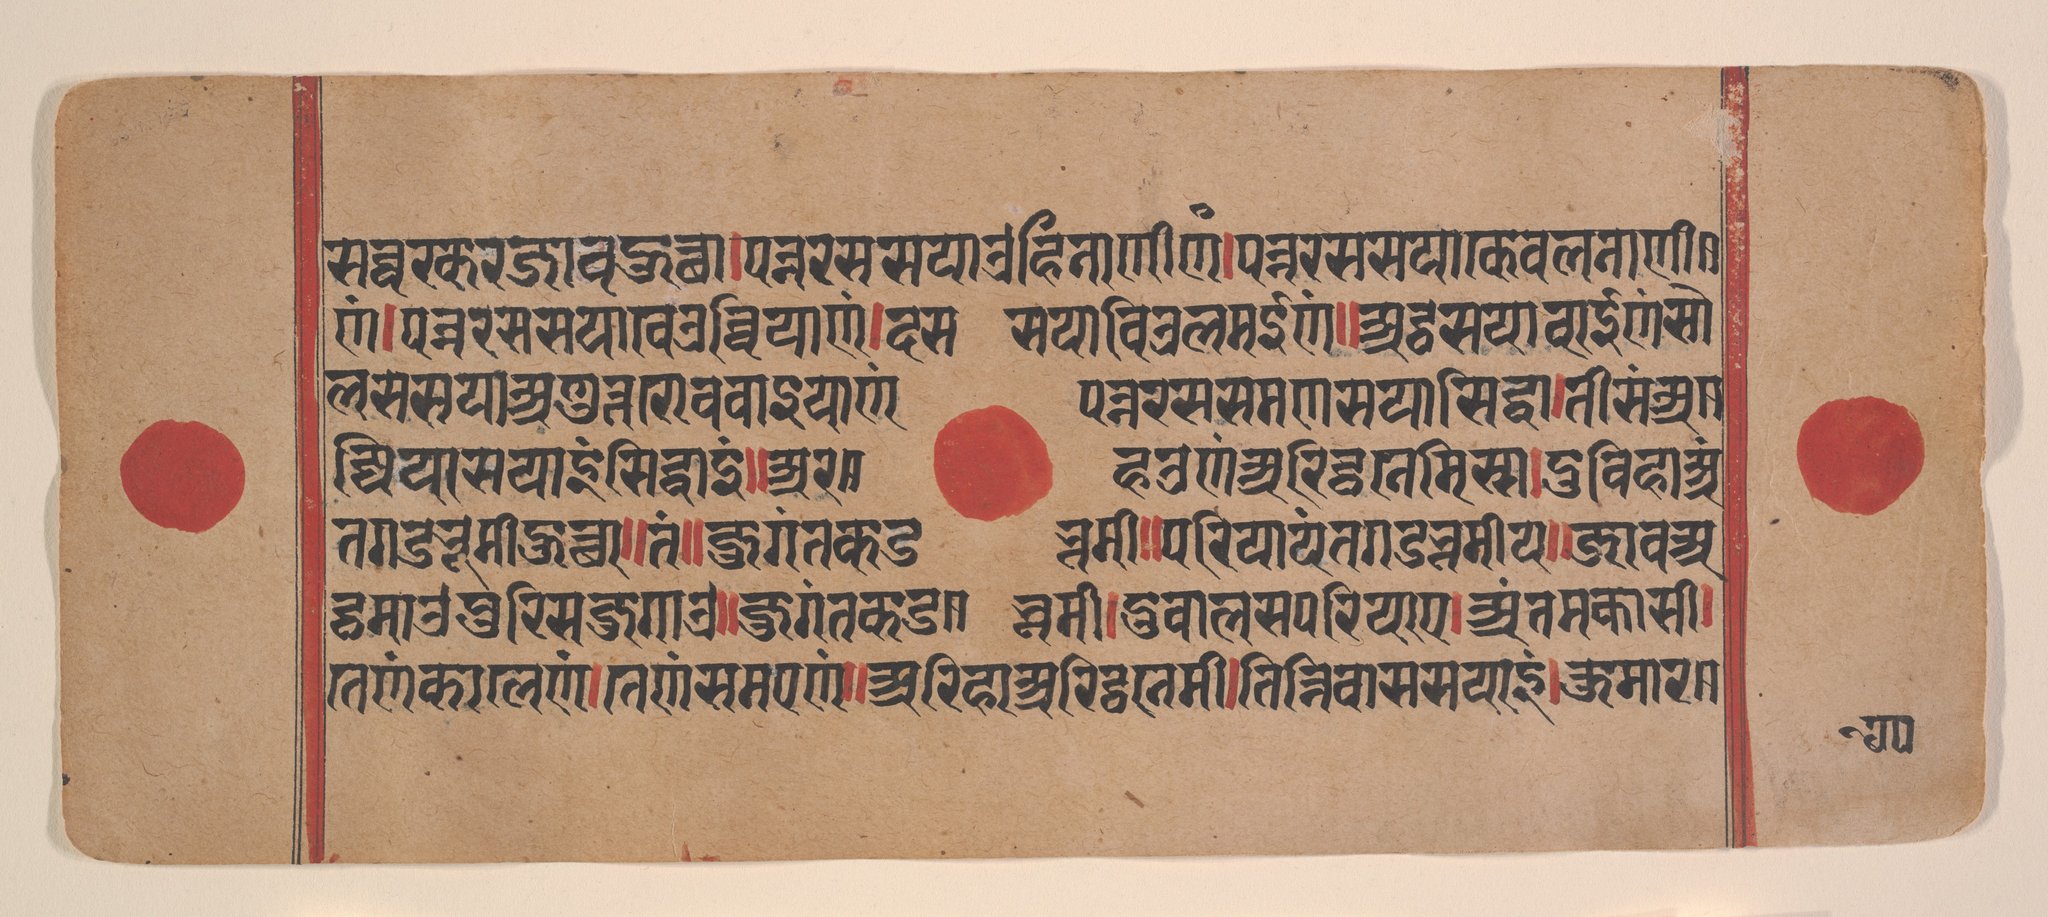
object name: folio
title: Page from a Dispersed Kalpa Sutra (Jain Book of Rituals)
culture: indian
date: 1401-1500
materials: gold, ink, paper, watercolor